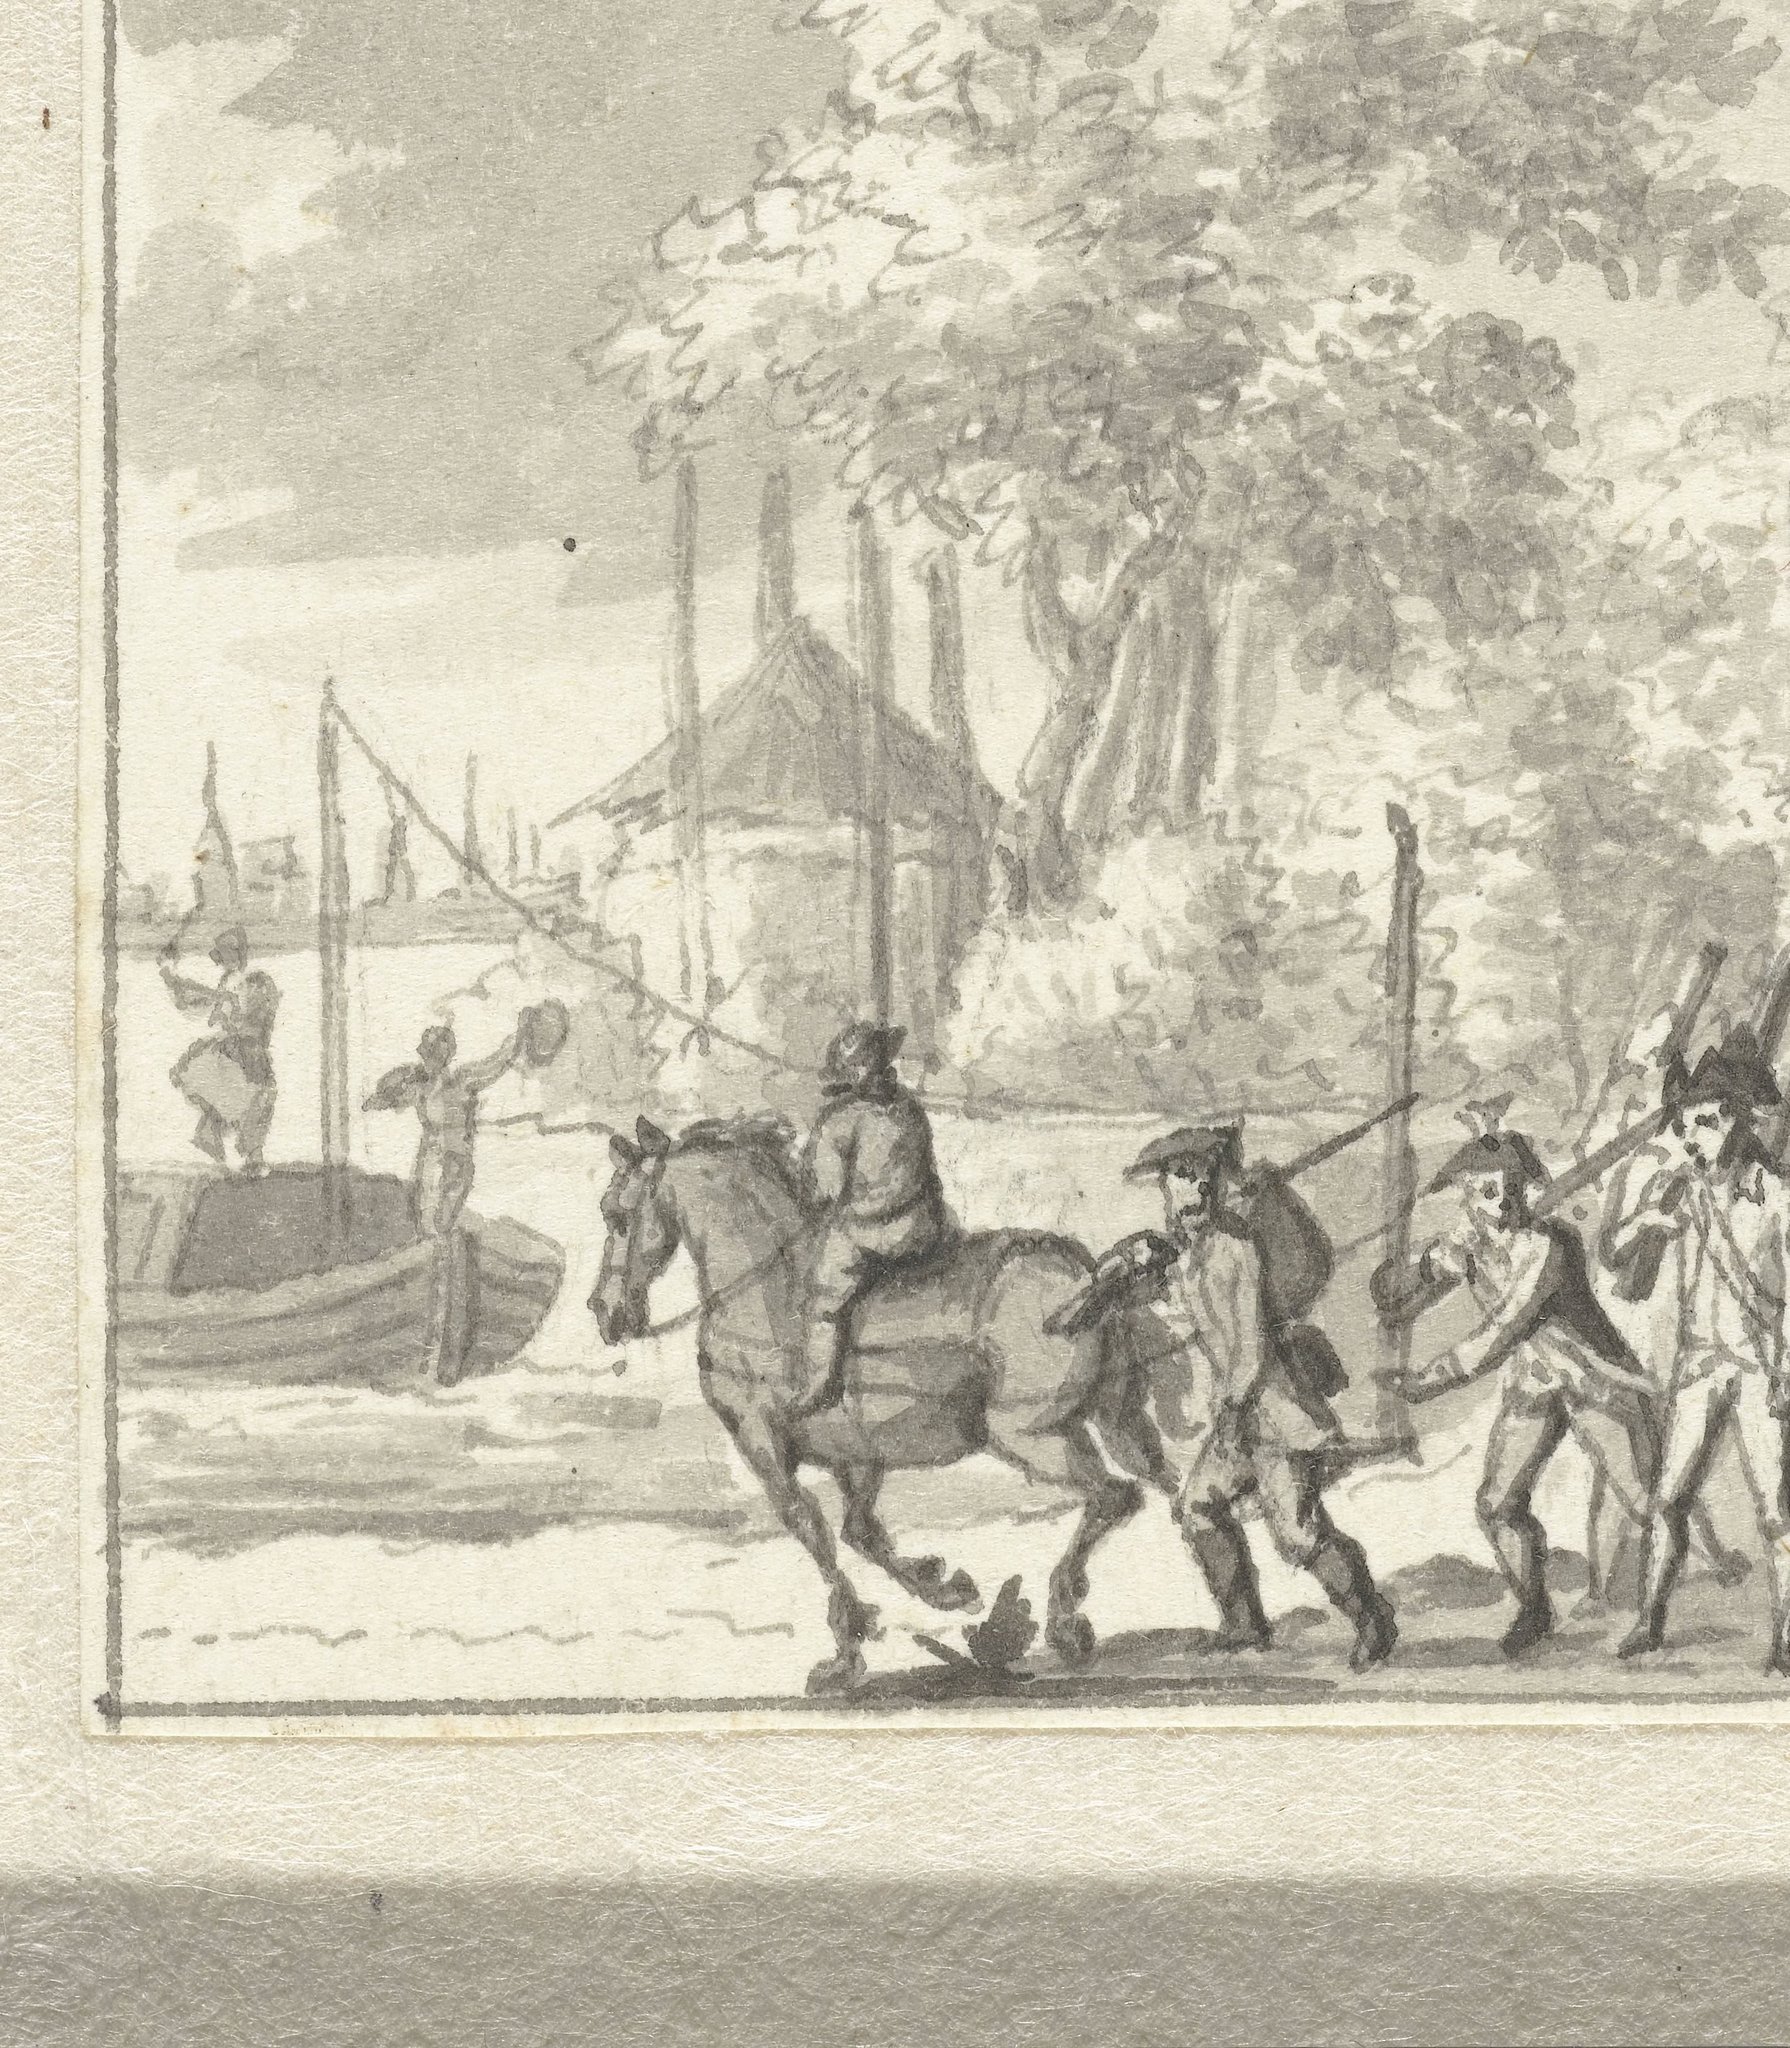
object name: drawing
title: In 't Jaar 1786 en 1787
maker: Anonymous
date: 1789-1810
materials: ink, paper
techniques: brush, pen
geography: netherlands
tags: patriots (1780-1795)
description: Patriotse legers in beweging, 1786 en 1787.